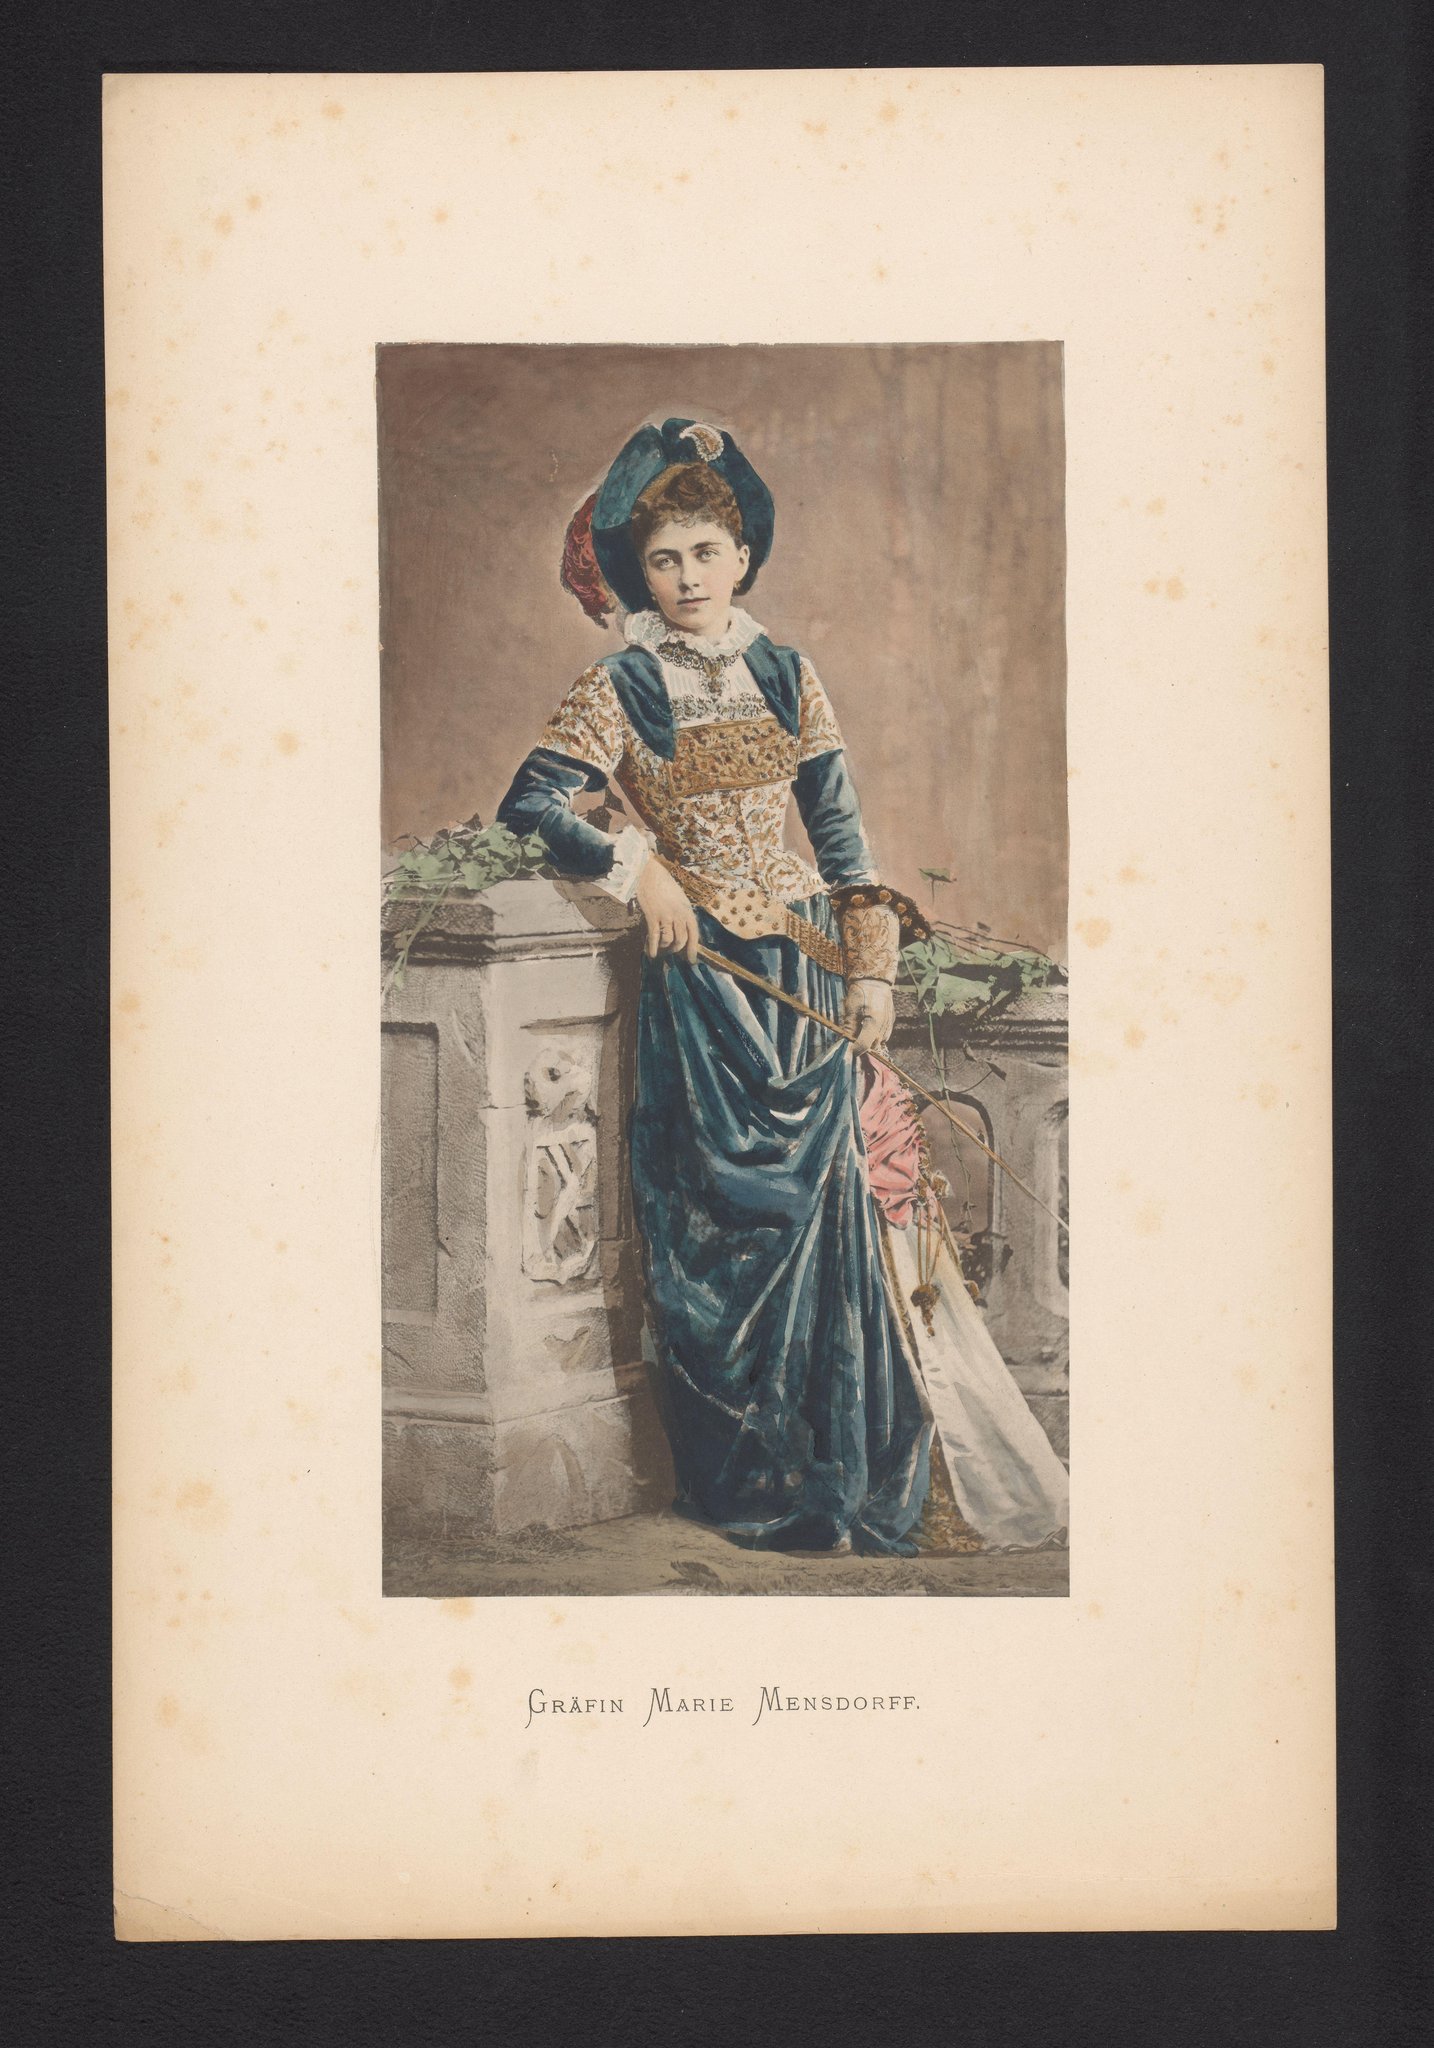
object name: photomechanical print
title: Portret van gravin Marie Mensdorff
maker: Anonymous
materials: paper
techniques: photograph, hand coloring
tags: historical persons - bb - woman, aristocracy; 'aristocratia' (ripa)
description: Deze prent maakt deel uit van een omslag met 86 prenten op 78 bladen en 11 tekstbladen.